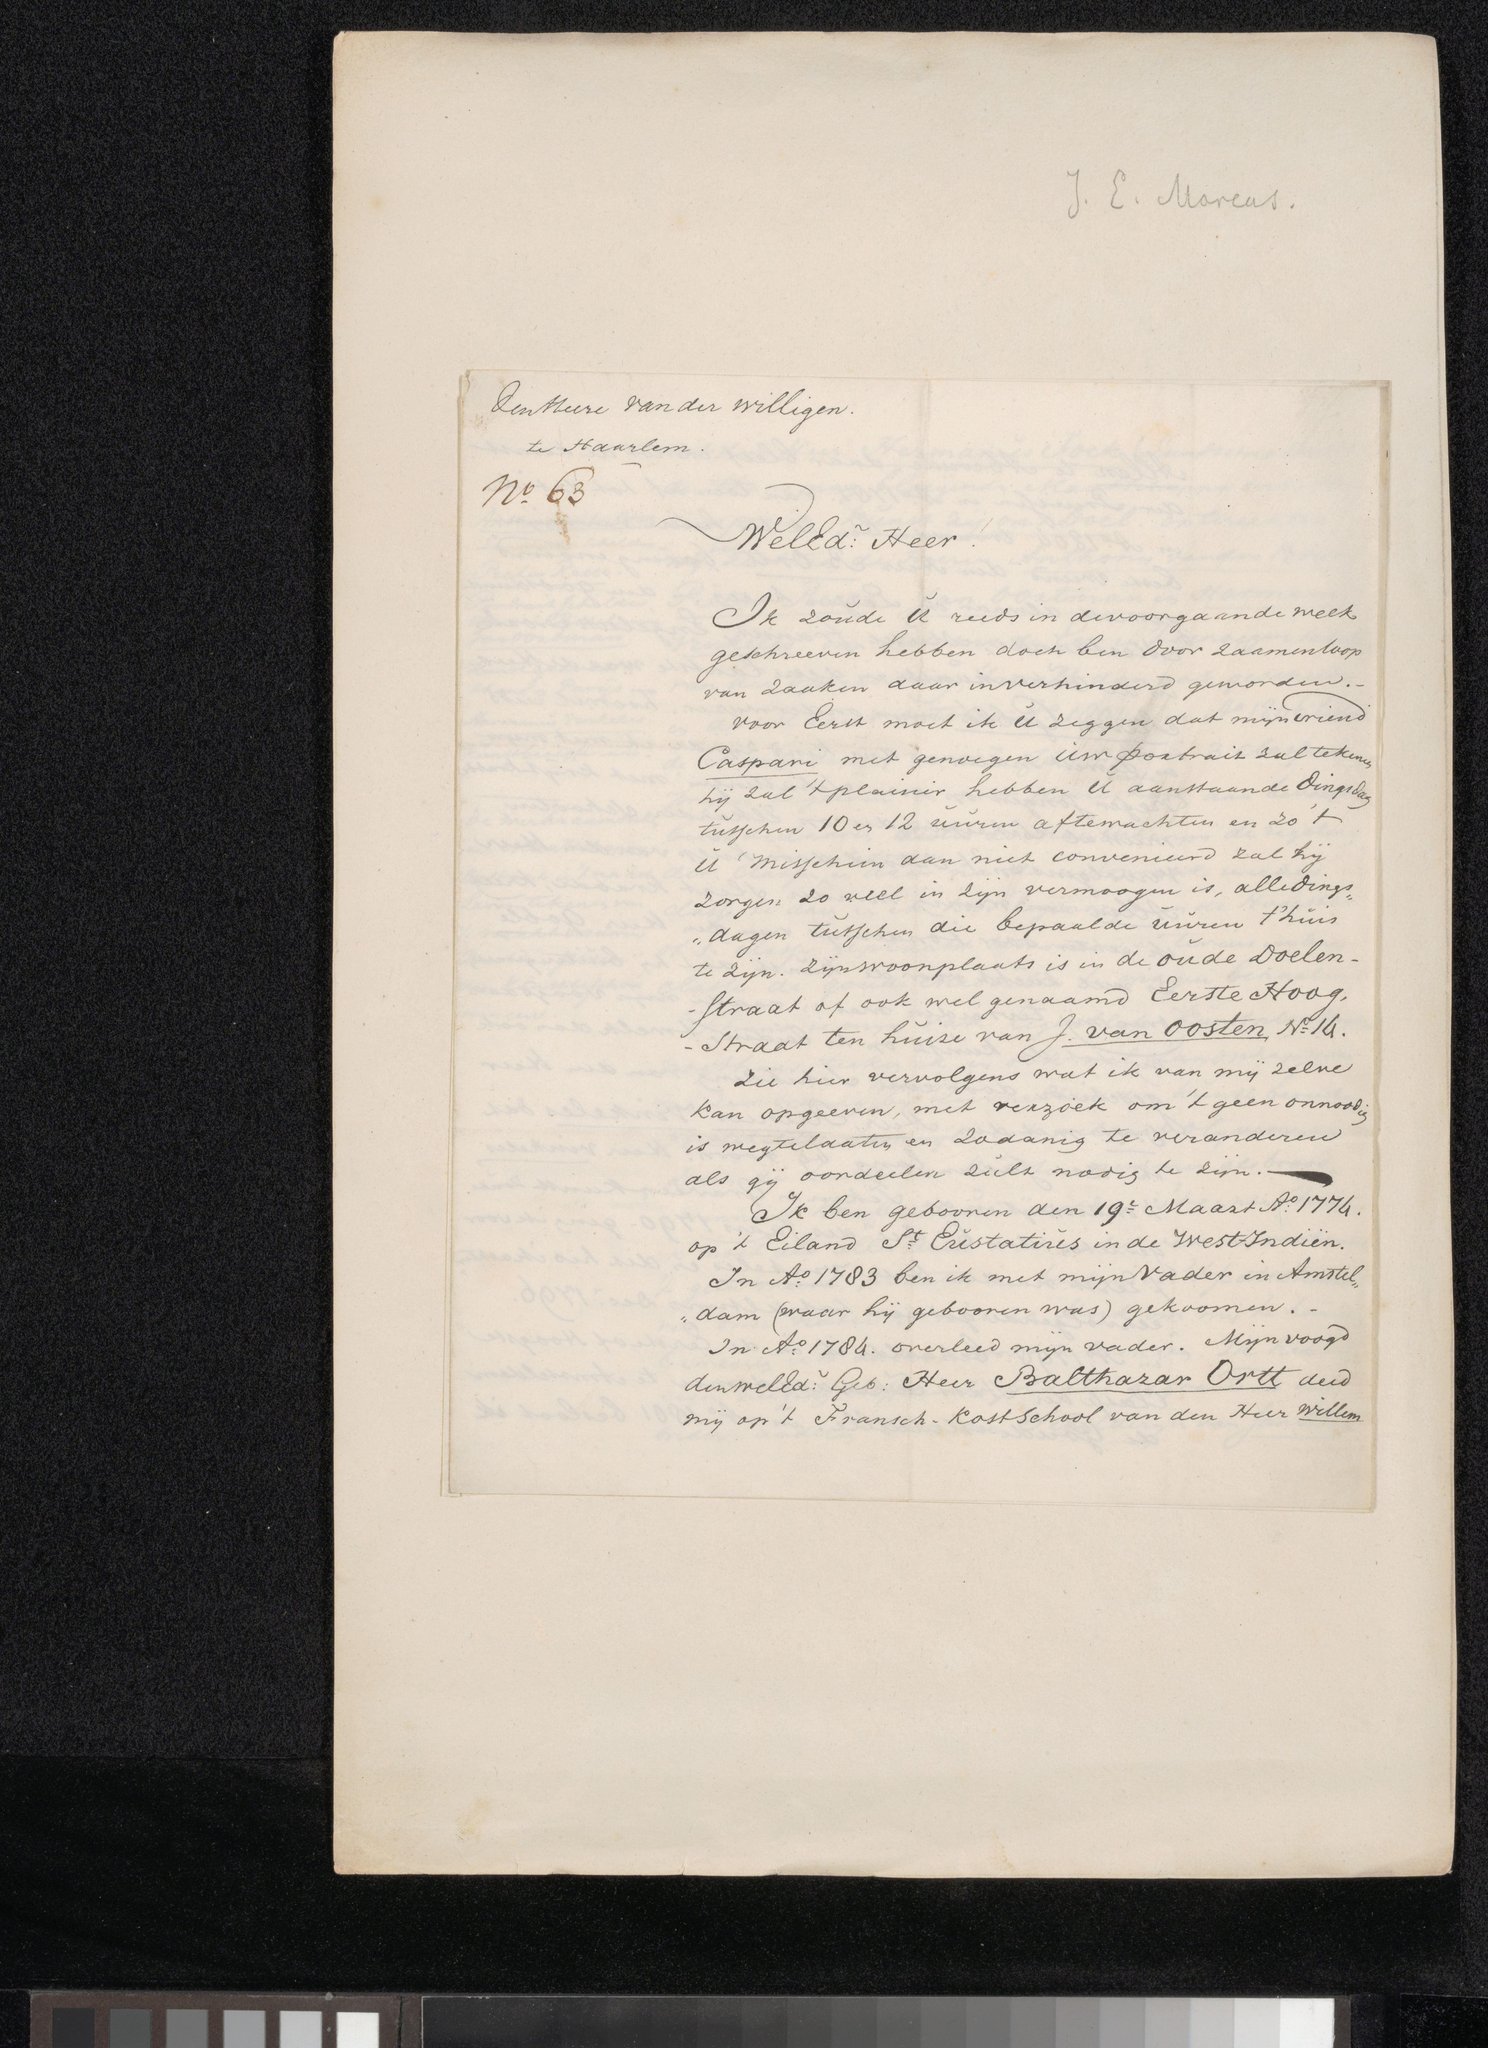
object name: letter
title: Brief aan Adriaan van der Willigen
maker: jacob ernst marcus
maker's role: draughtsman, print maker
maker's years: 1774-1826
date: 1815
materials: ink, paper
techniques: pen, writing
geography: amsterdam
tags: steven goblé, rotterdam, haarlem, adriaan van der willigen, amsterdam, draughtsman, hendrik willem caspari, reinier vinkeles (i), drawing, distribution of awards ~ art contest, the graphic arts, family life, education, tuition of the artist (in general), historical persons (portraits and scenes from the life)